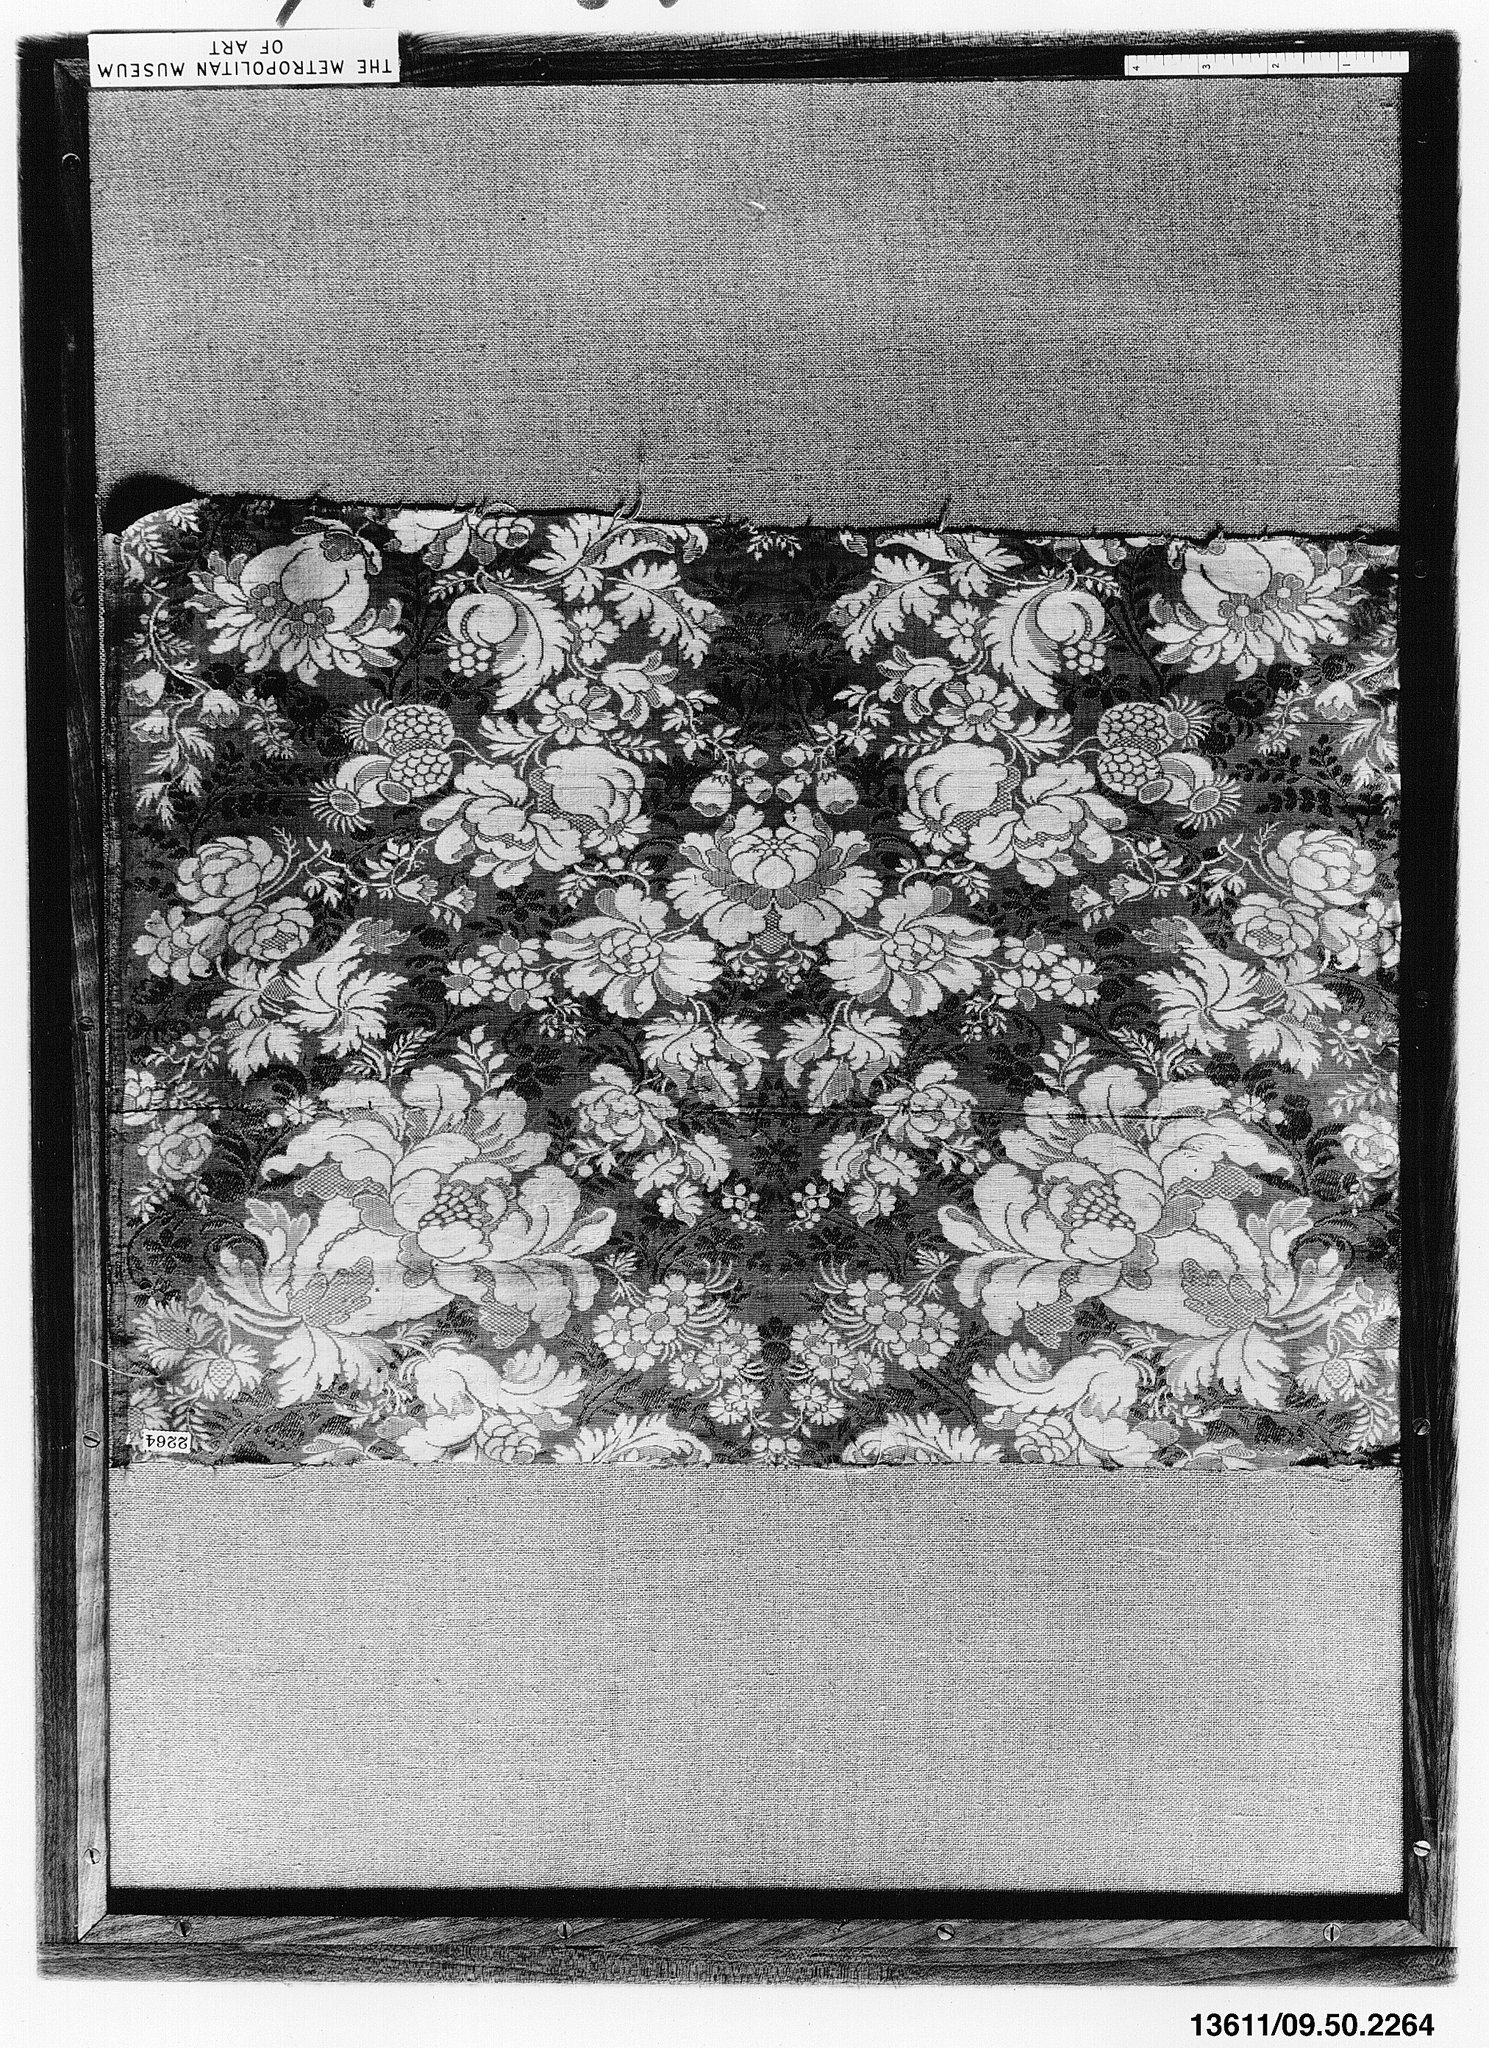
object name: piece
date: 1730-1735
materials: silk